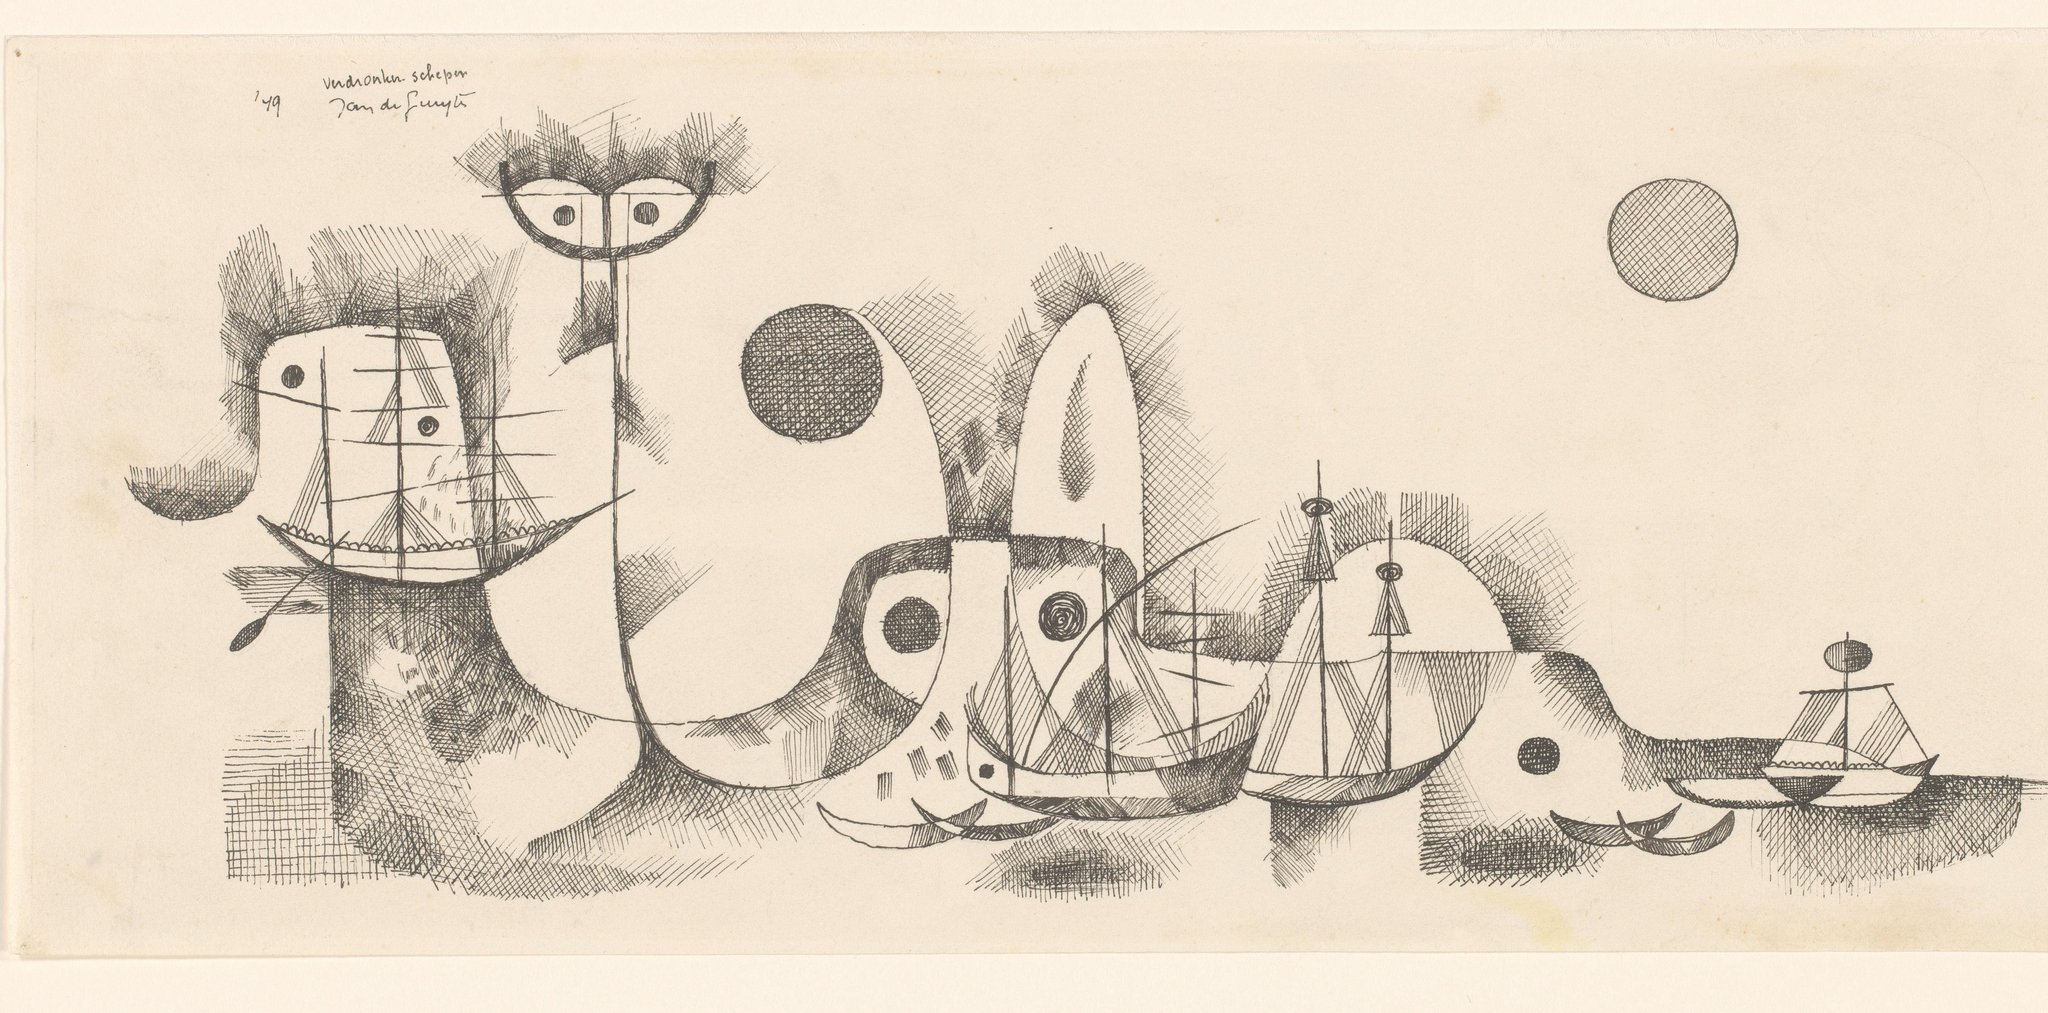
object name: drawing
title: Verdronken schepen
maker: jan de gruijter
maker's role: draughtsman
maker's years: 1917-1951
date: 1949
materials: ink, paper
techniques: pen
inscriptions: signature, date and inscription: ‘Verdronken schepen/ ´49/ Jan de Gruyter’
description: Verschillende gedeformeerde schepen op een rij.